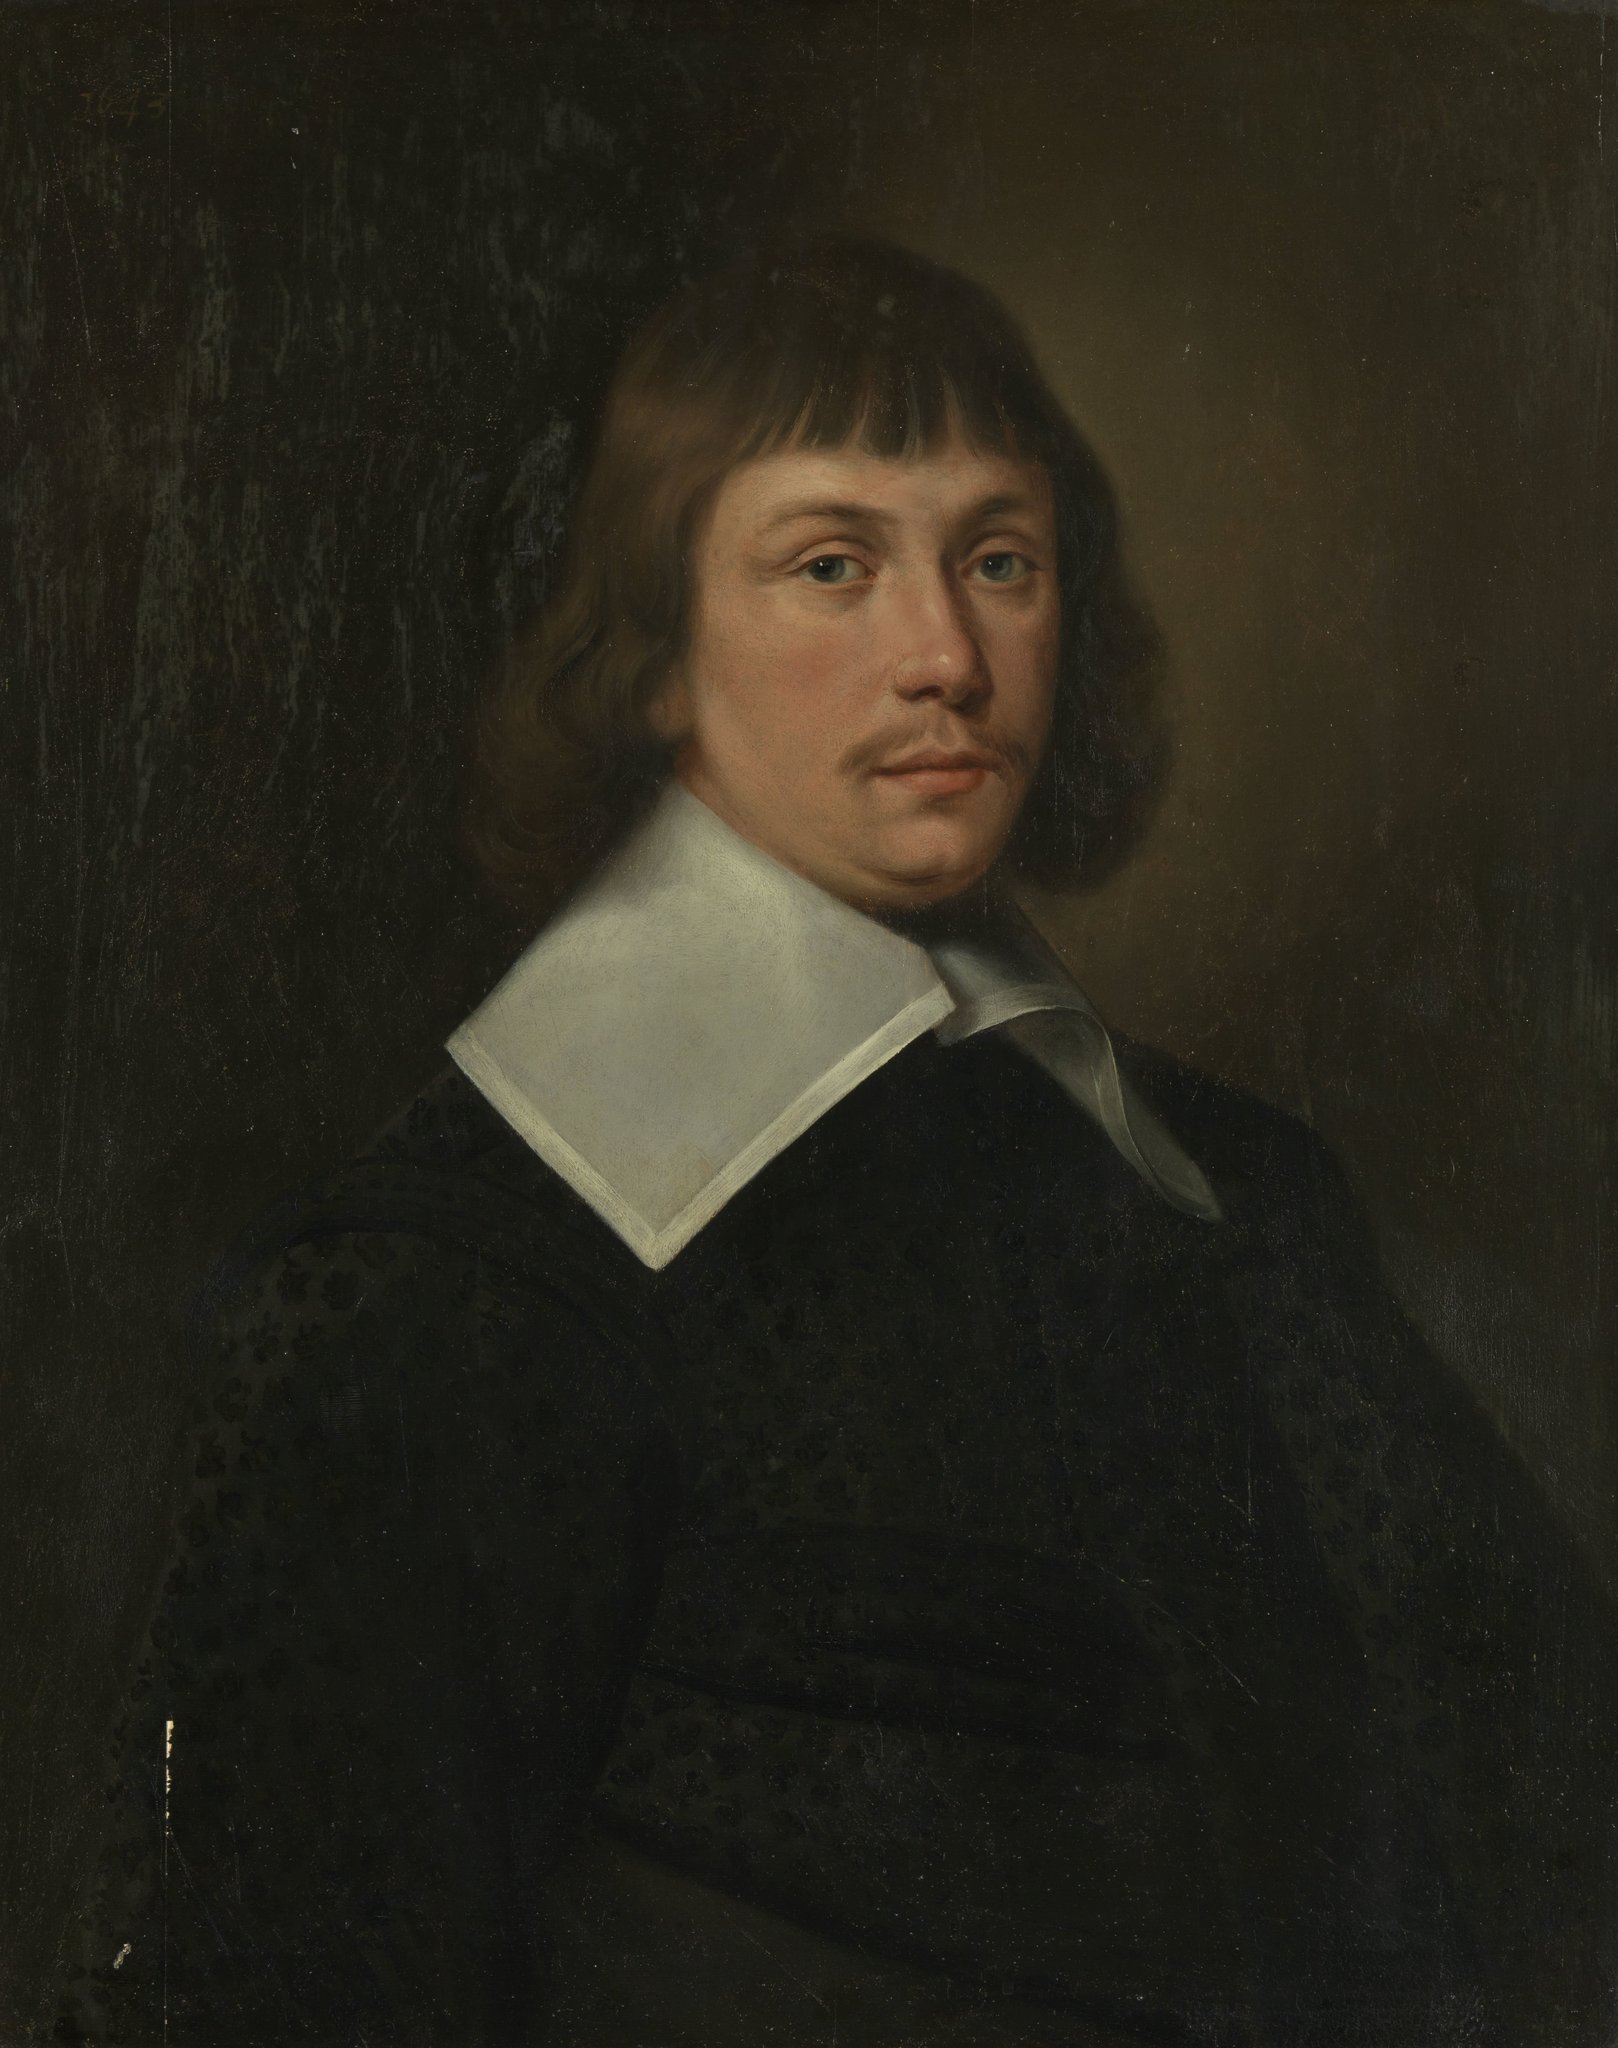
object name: painting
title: Portrait of a man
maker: Anonymous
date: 1643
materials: oil, panel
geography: northern netherlands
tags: historical persons not known by name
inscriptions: date: ‘1643’